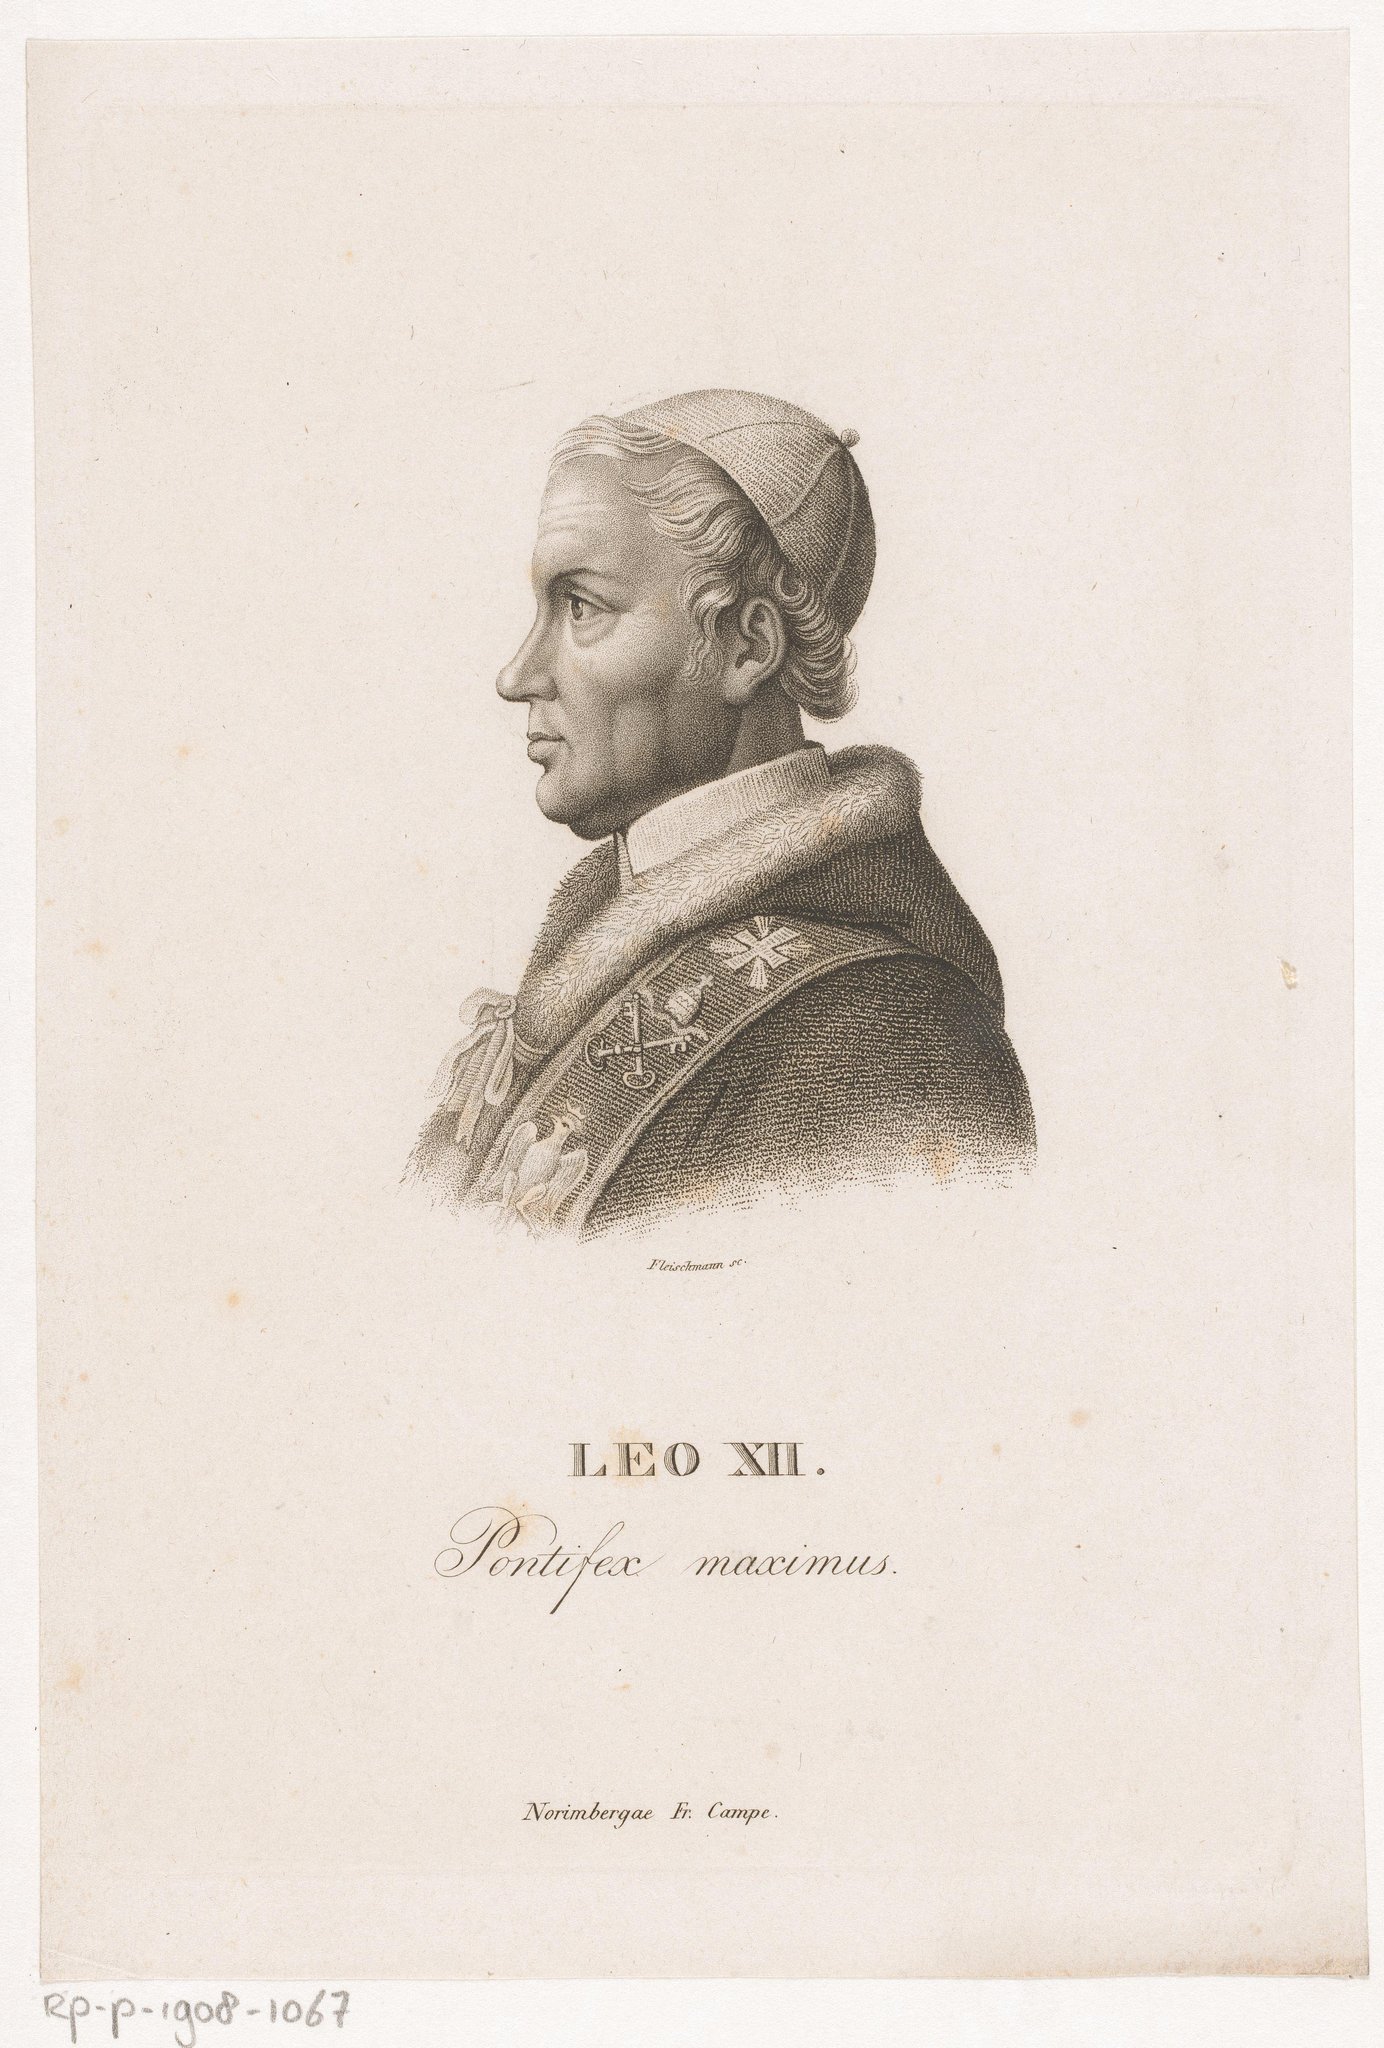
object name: print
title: Portret van paus Leo XII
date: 1801-1834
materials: paper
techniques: stippling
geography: nuremberg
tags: rome, historical persons, pope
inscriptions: collector's mark: Lugt 2228